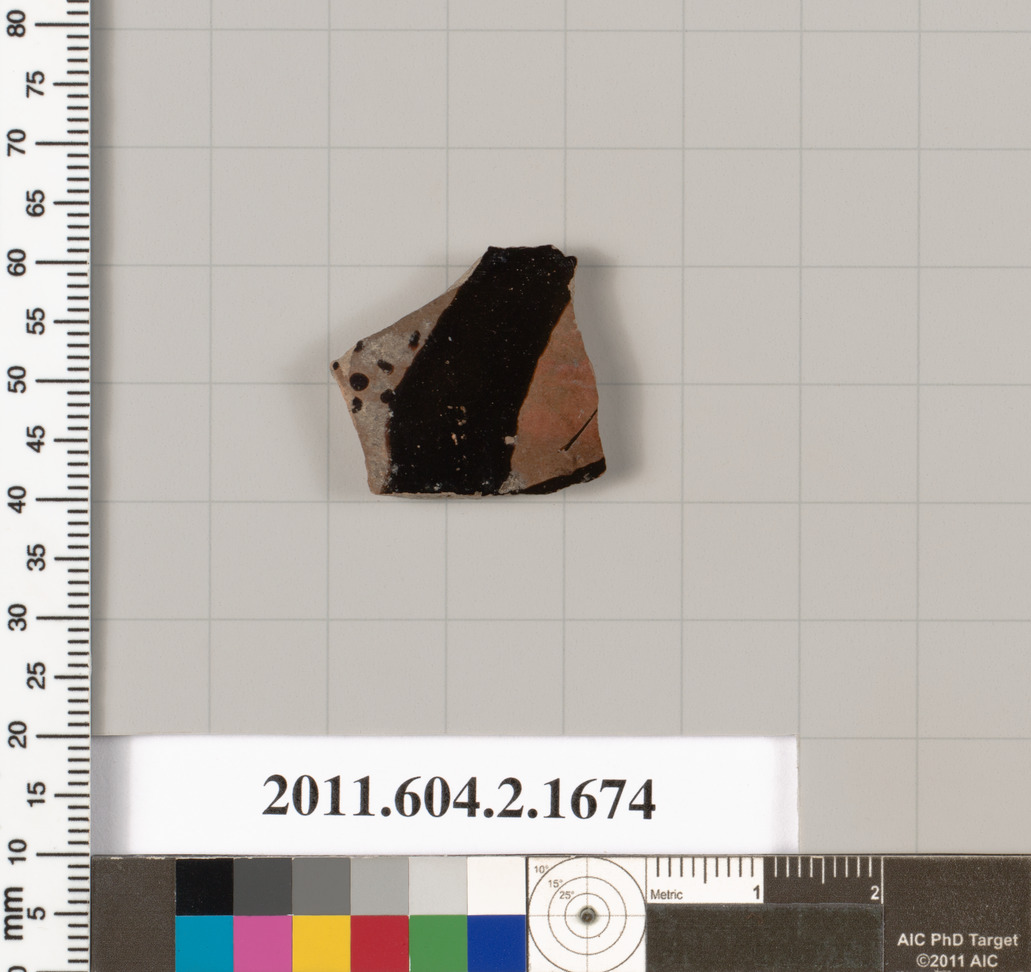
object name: skyphos fragment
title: Terracotta fragment of a skyphos (deep drinking cup)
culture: greek, attic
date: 450-401 BCE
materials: terracotta